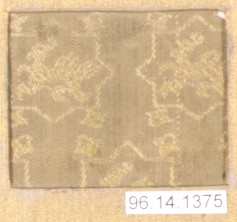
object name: piece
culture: japanese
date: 1701-1900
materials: silk